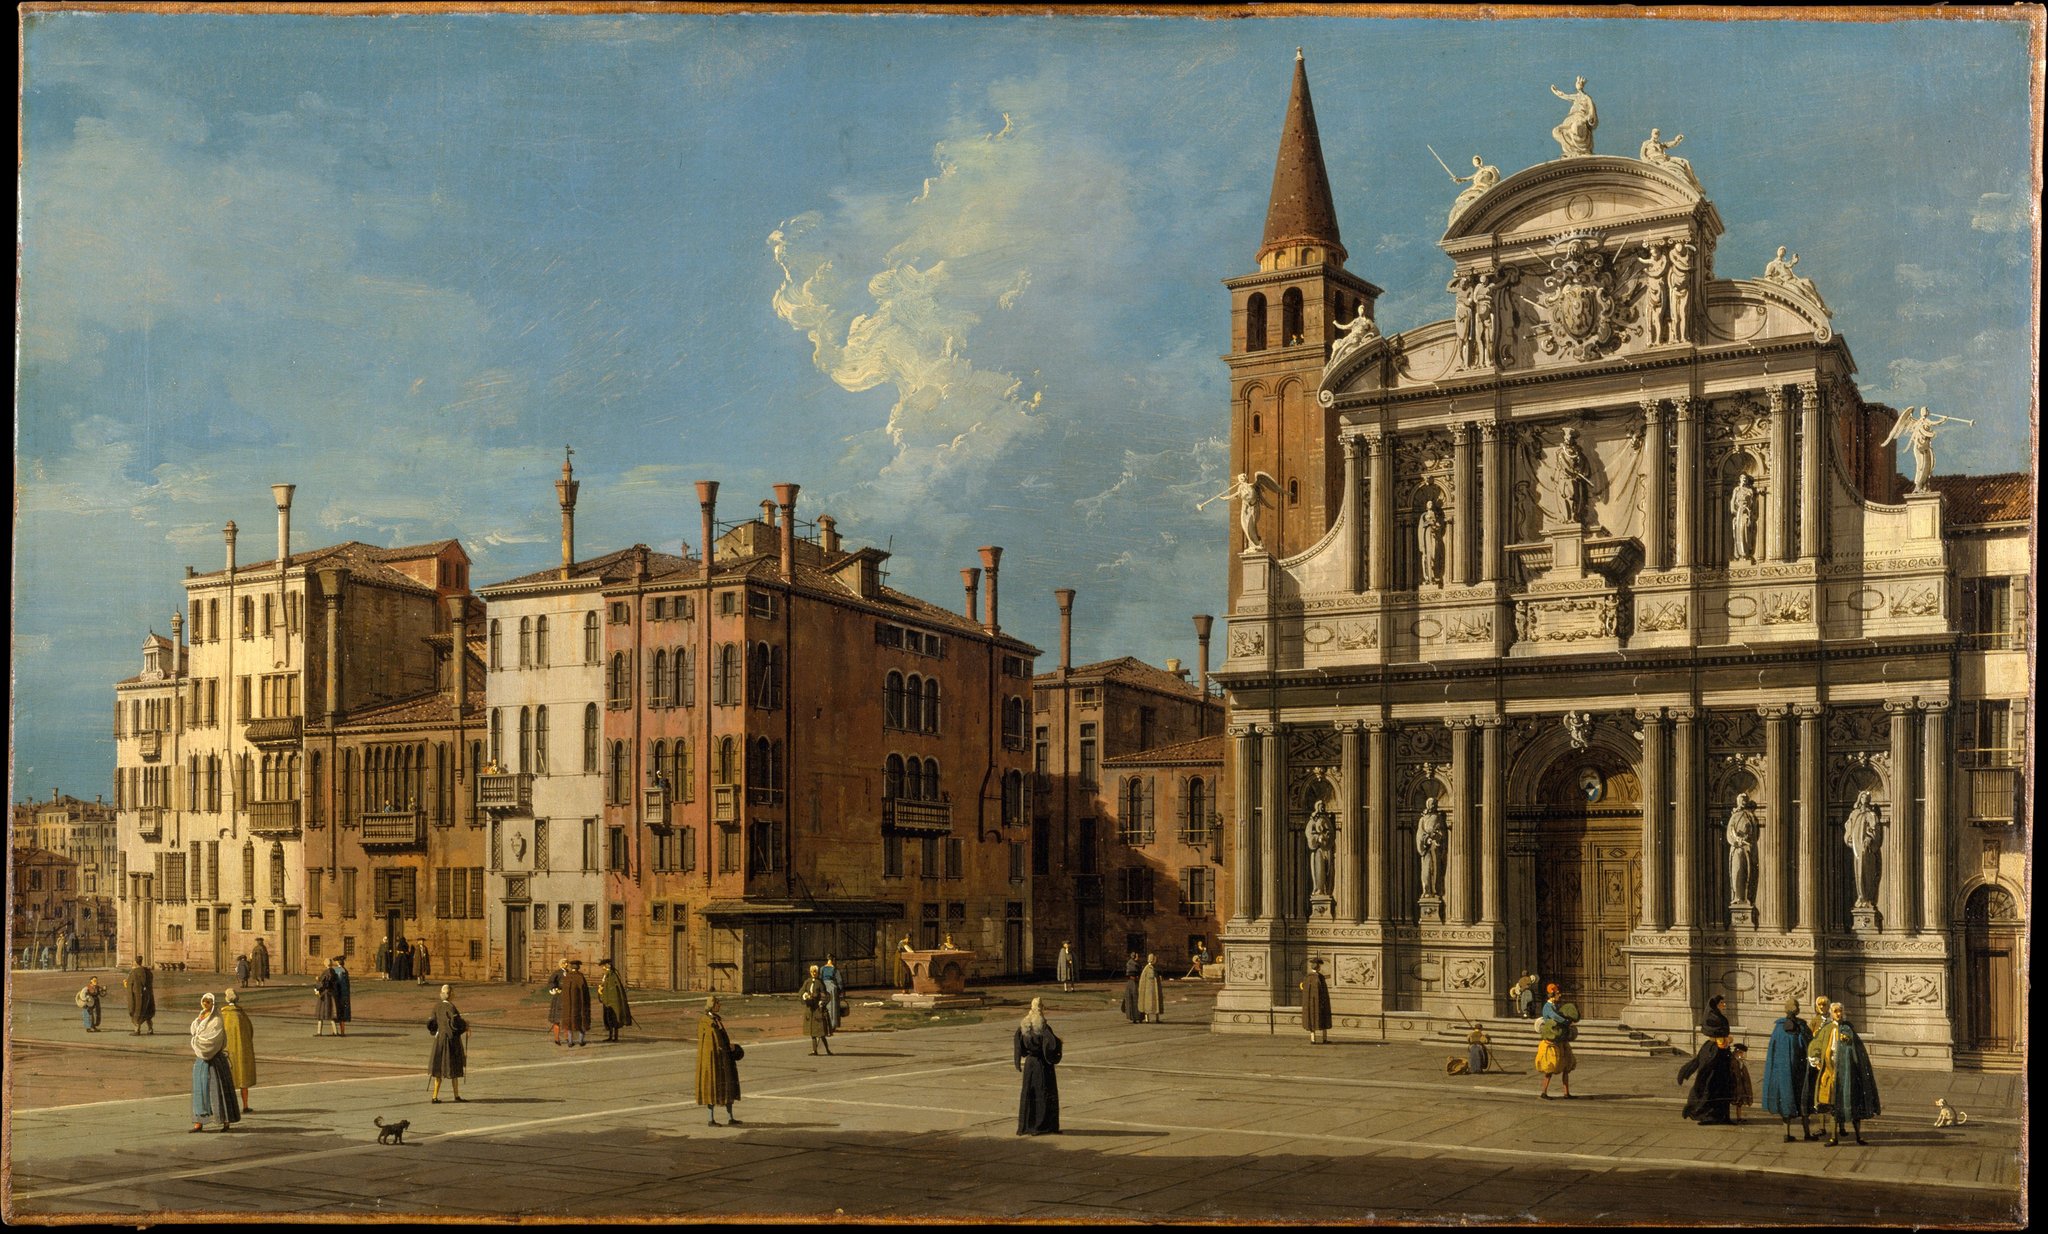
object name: painting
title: Campo Santa Maria Zobenigo, Venice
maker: canaletto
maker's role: artist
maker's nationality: italian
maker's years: 1697-1768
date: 1730-1739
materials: canvas, oil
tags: buildings,towers,cities,venice